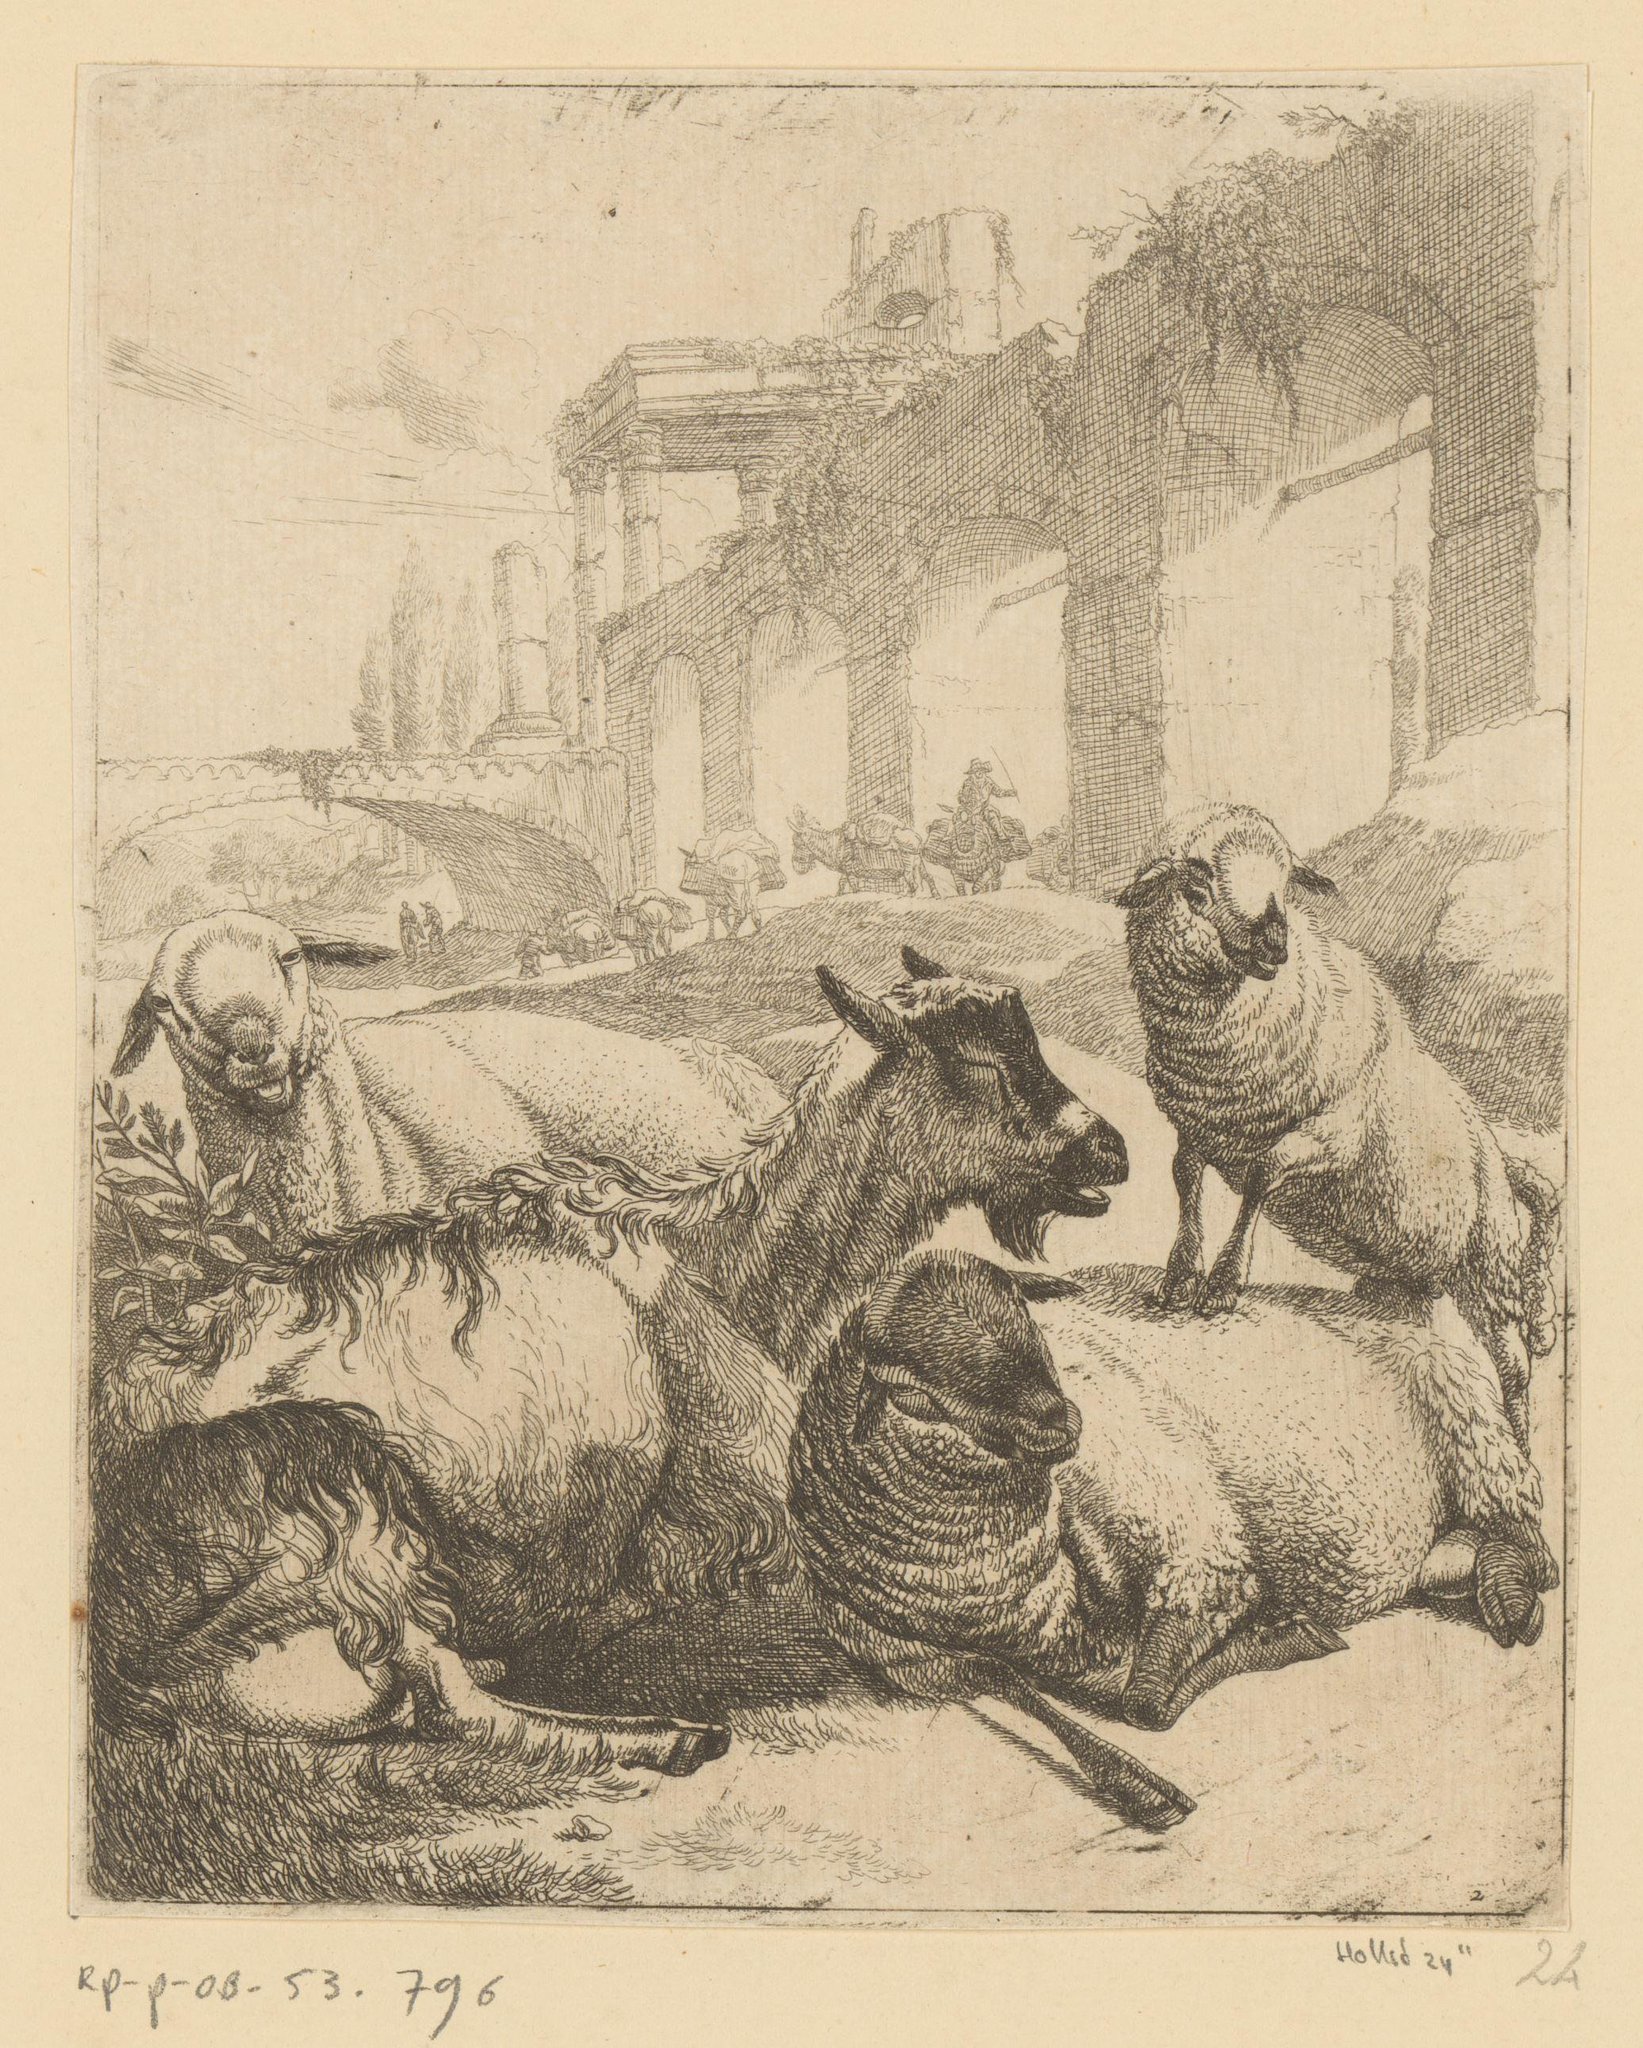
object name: print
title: Schapen, geiten en koeien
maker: johann heinrich roos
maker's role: draughtsman, print maker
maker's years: 1631-1685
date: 1668-1670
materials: paper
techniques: engraving, etching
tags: landscapes, sheep, goat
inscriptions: collector's mark: Lugt 240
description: Serie van twaalf prenten, waarvan één titelprent. Deze staat rechtsonder genummerd met een 2.